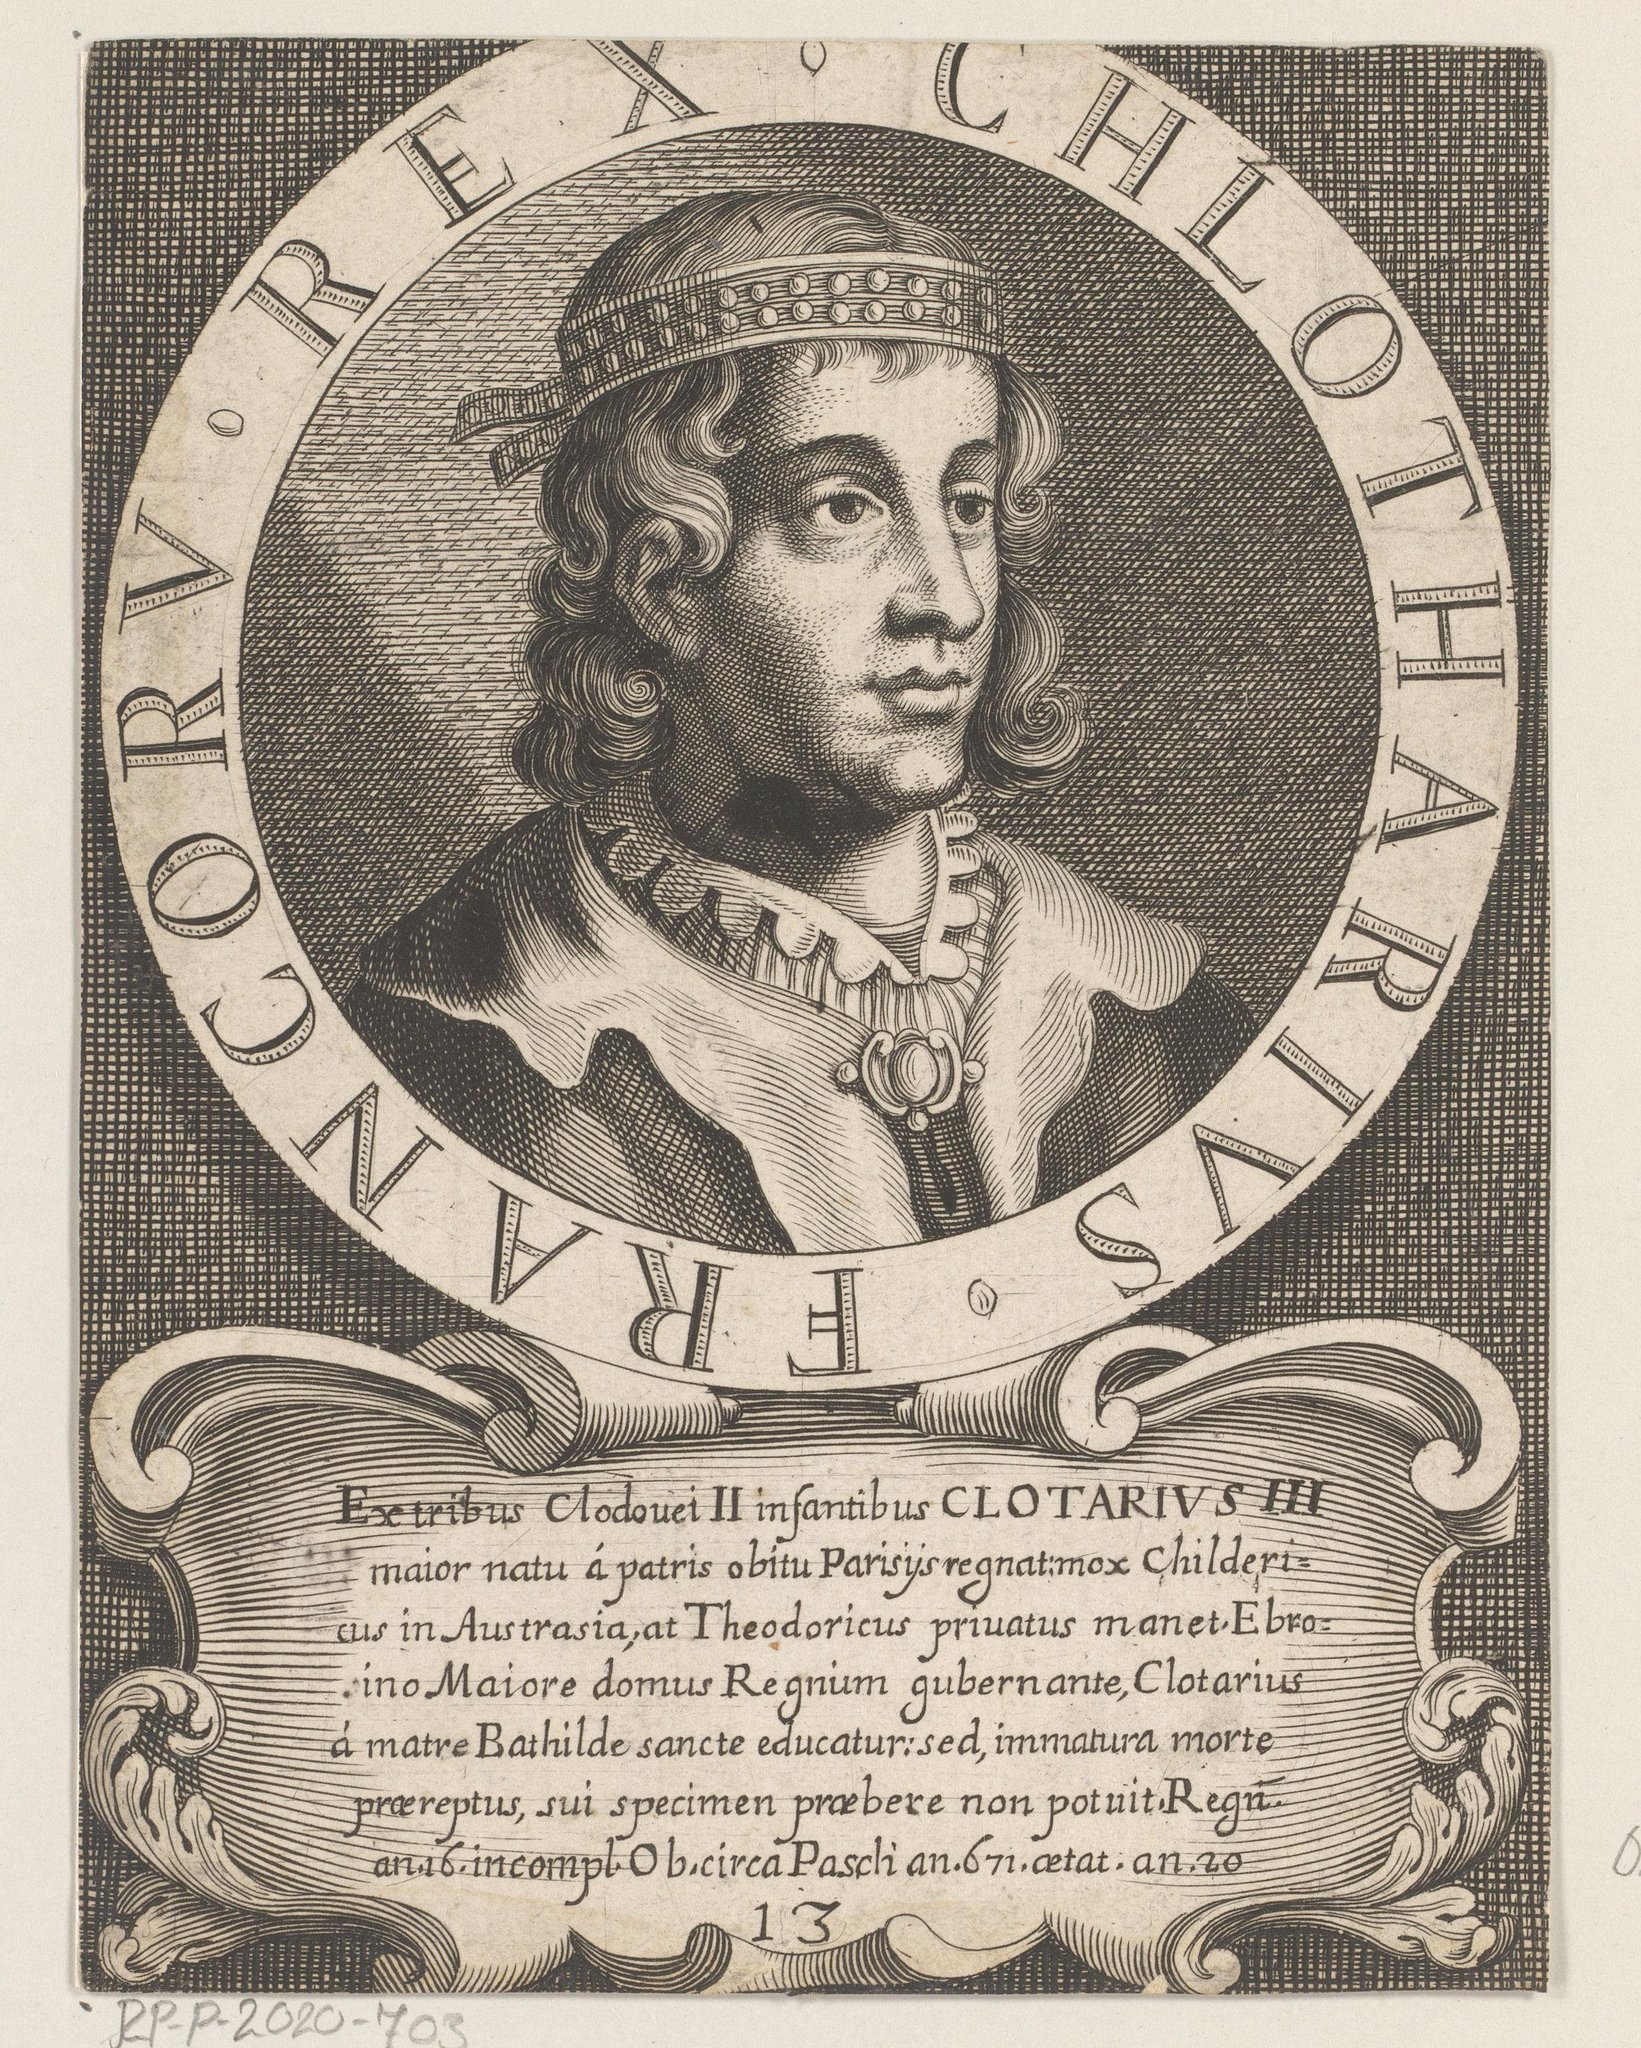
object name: print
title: Portret van Clovis III, koning van Austrasië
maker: Anonymous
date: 1630-1699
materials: paper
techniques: engraving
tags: historical persons, ruler, sovereign